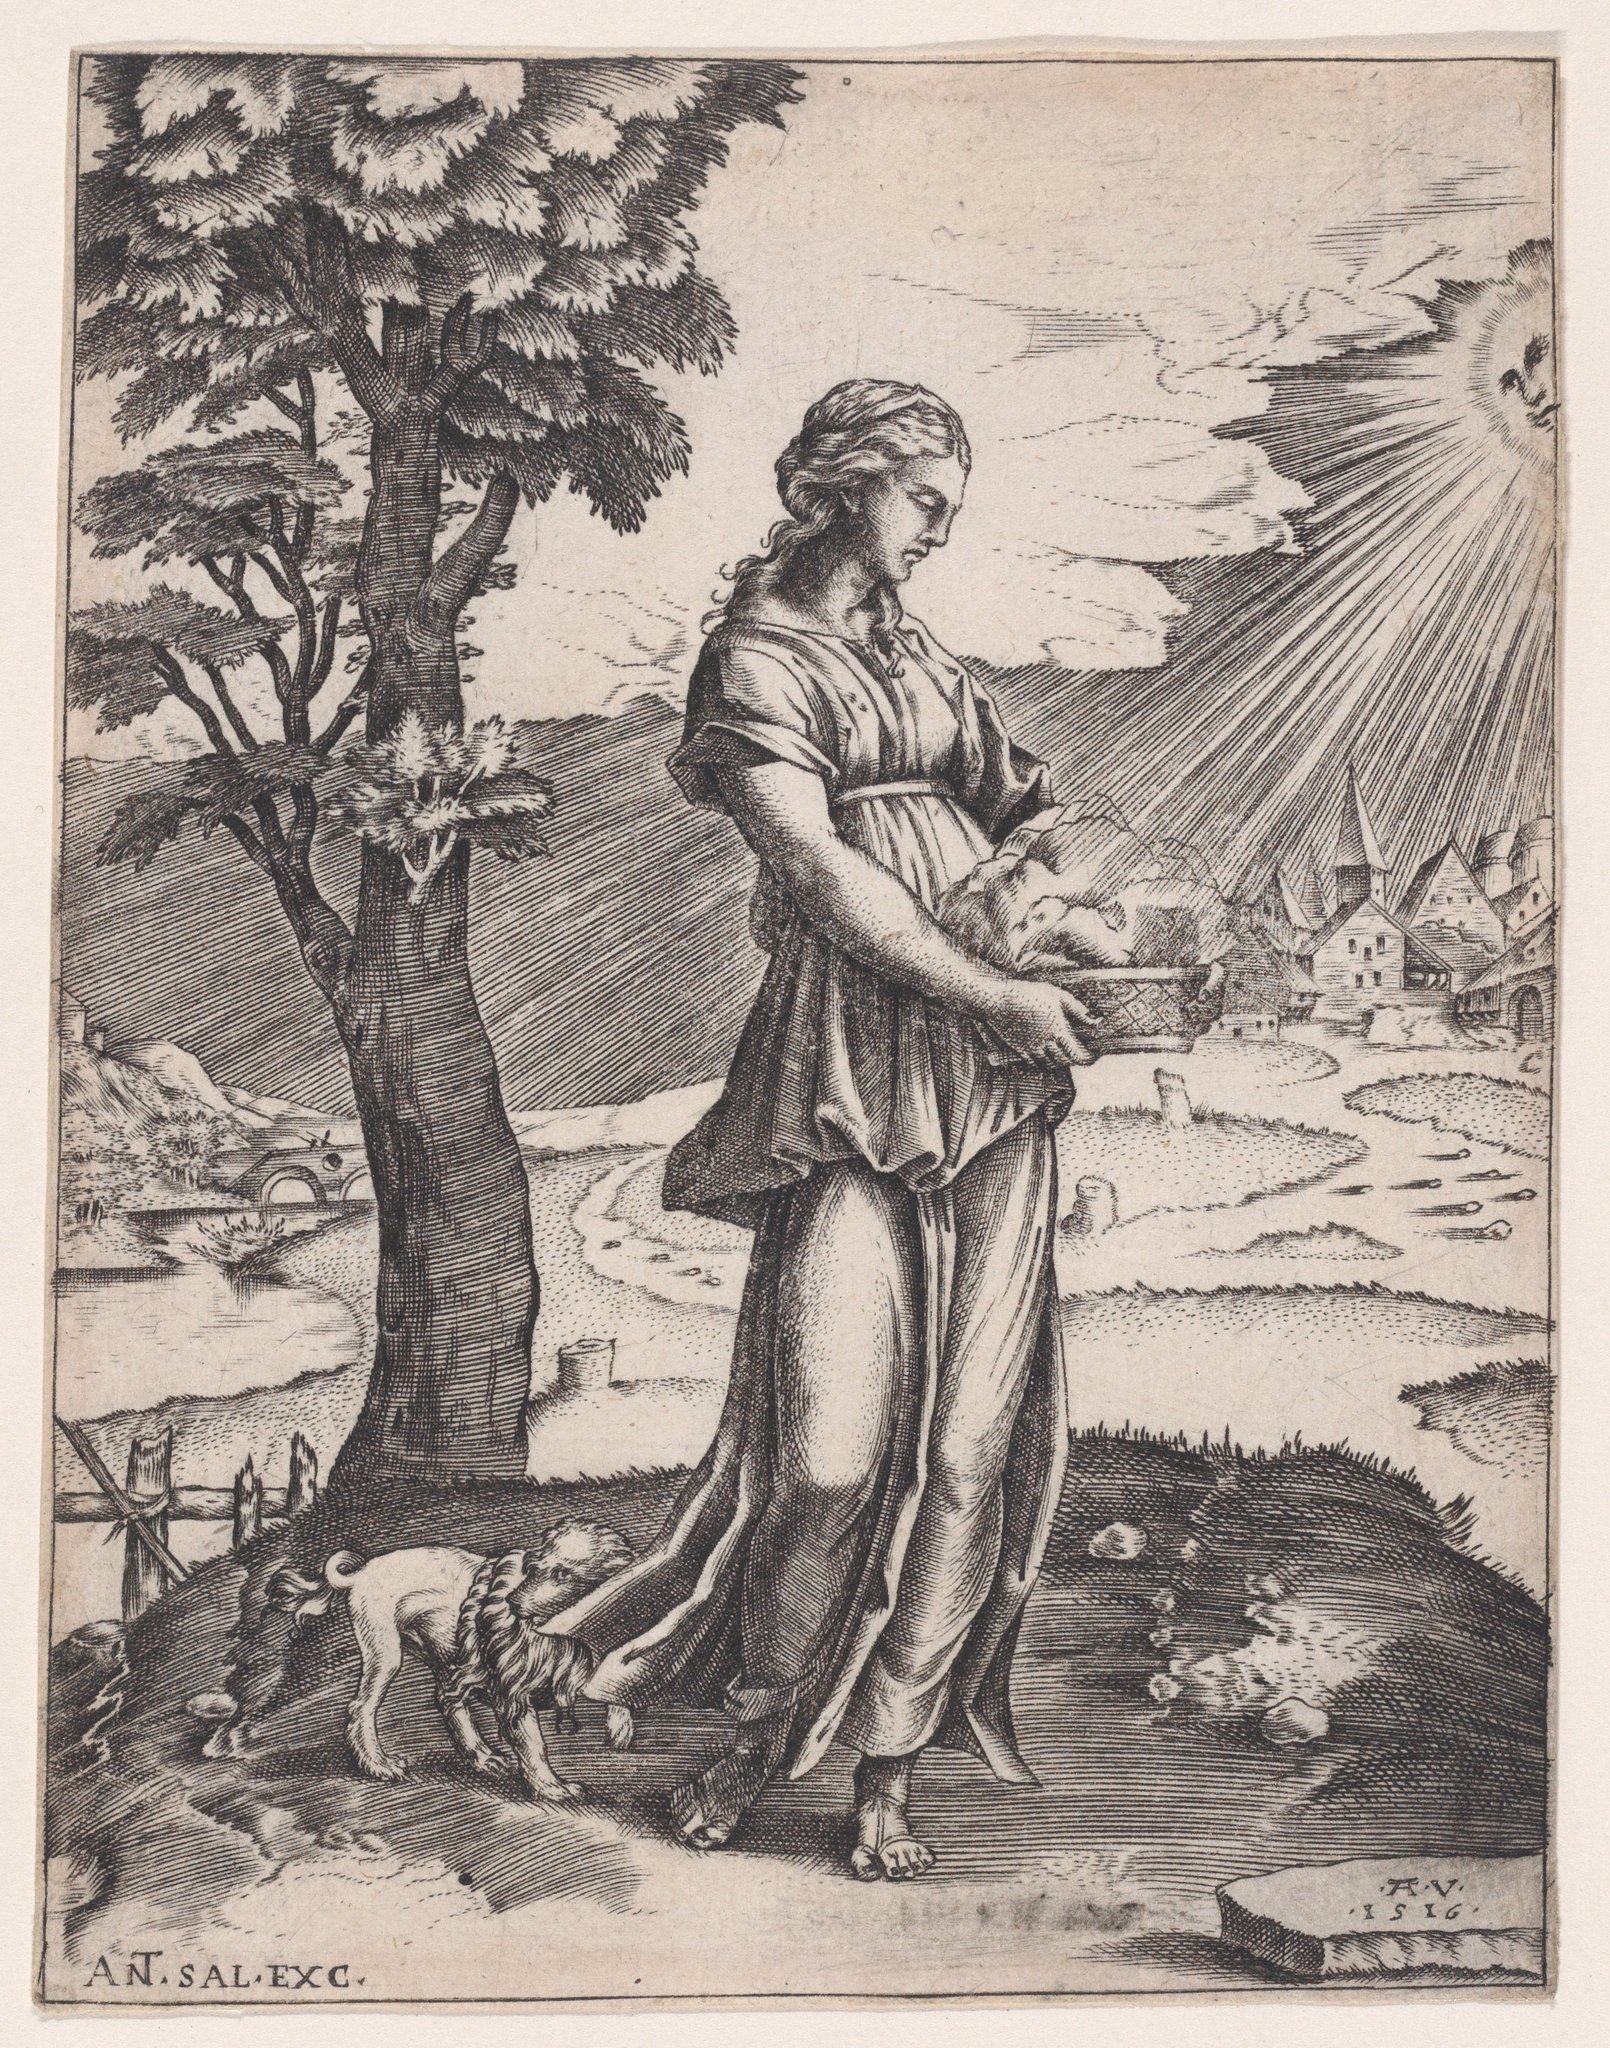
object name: print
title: The Cumaean Sibyl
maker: agostino veneziano (agostino dei musi)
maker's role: artist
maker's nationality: italian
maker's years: 1490-1536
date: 1516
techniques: engraving